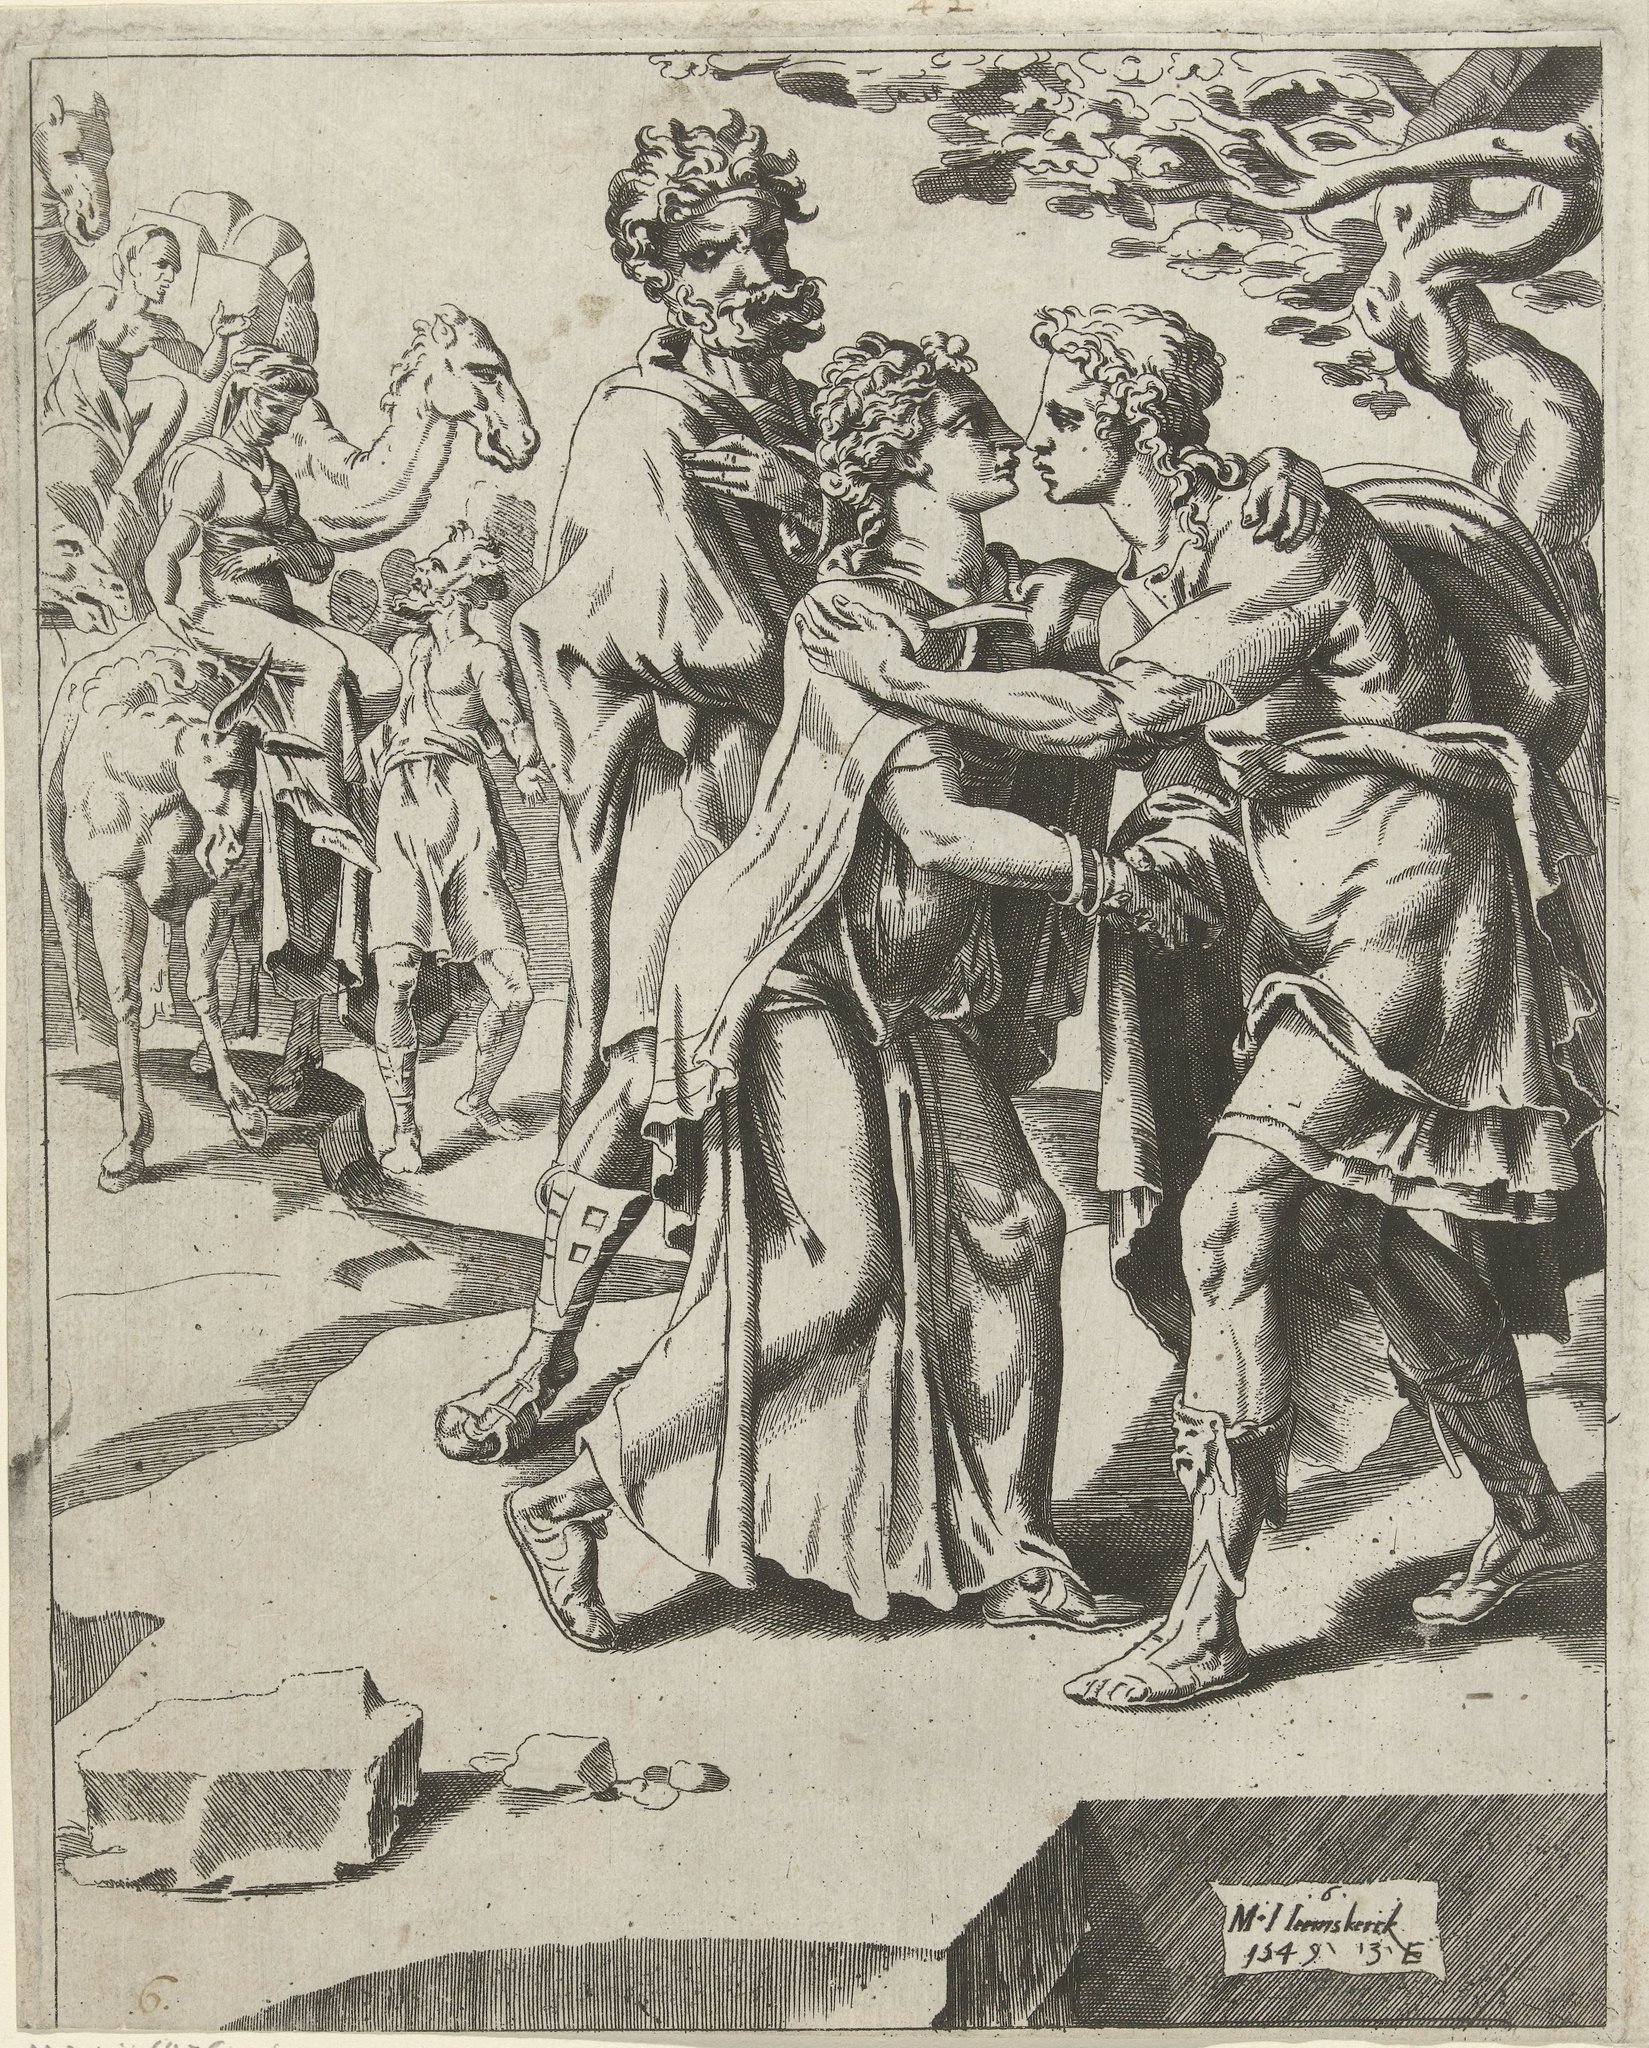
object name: print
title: Isaak groet Rebekka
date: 1549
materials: paper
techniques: etching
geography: haarlem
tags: isaac, walking in the fields, meets rebekah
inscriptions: number: ‘6’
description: Terug in Kanaän worden Eliëzer en Rebekka verwelkomd door Isaak. Rebekka begroet Isaak met een kus. De prent maakt deel uit van een serie over Isaaks zoektocht naar een vrouw.